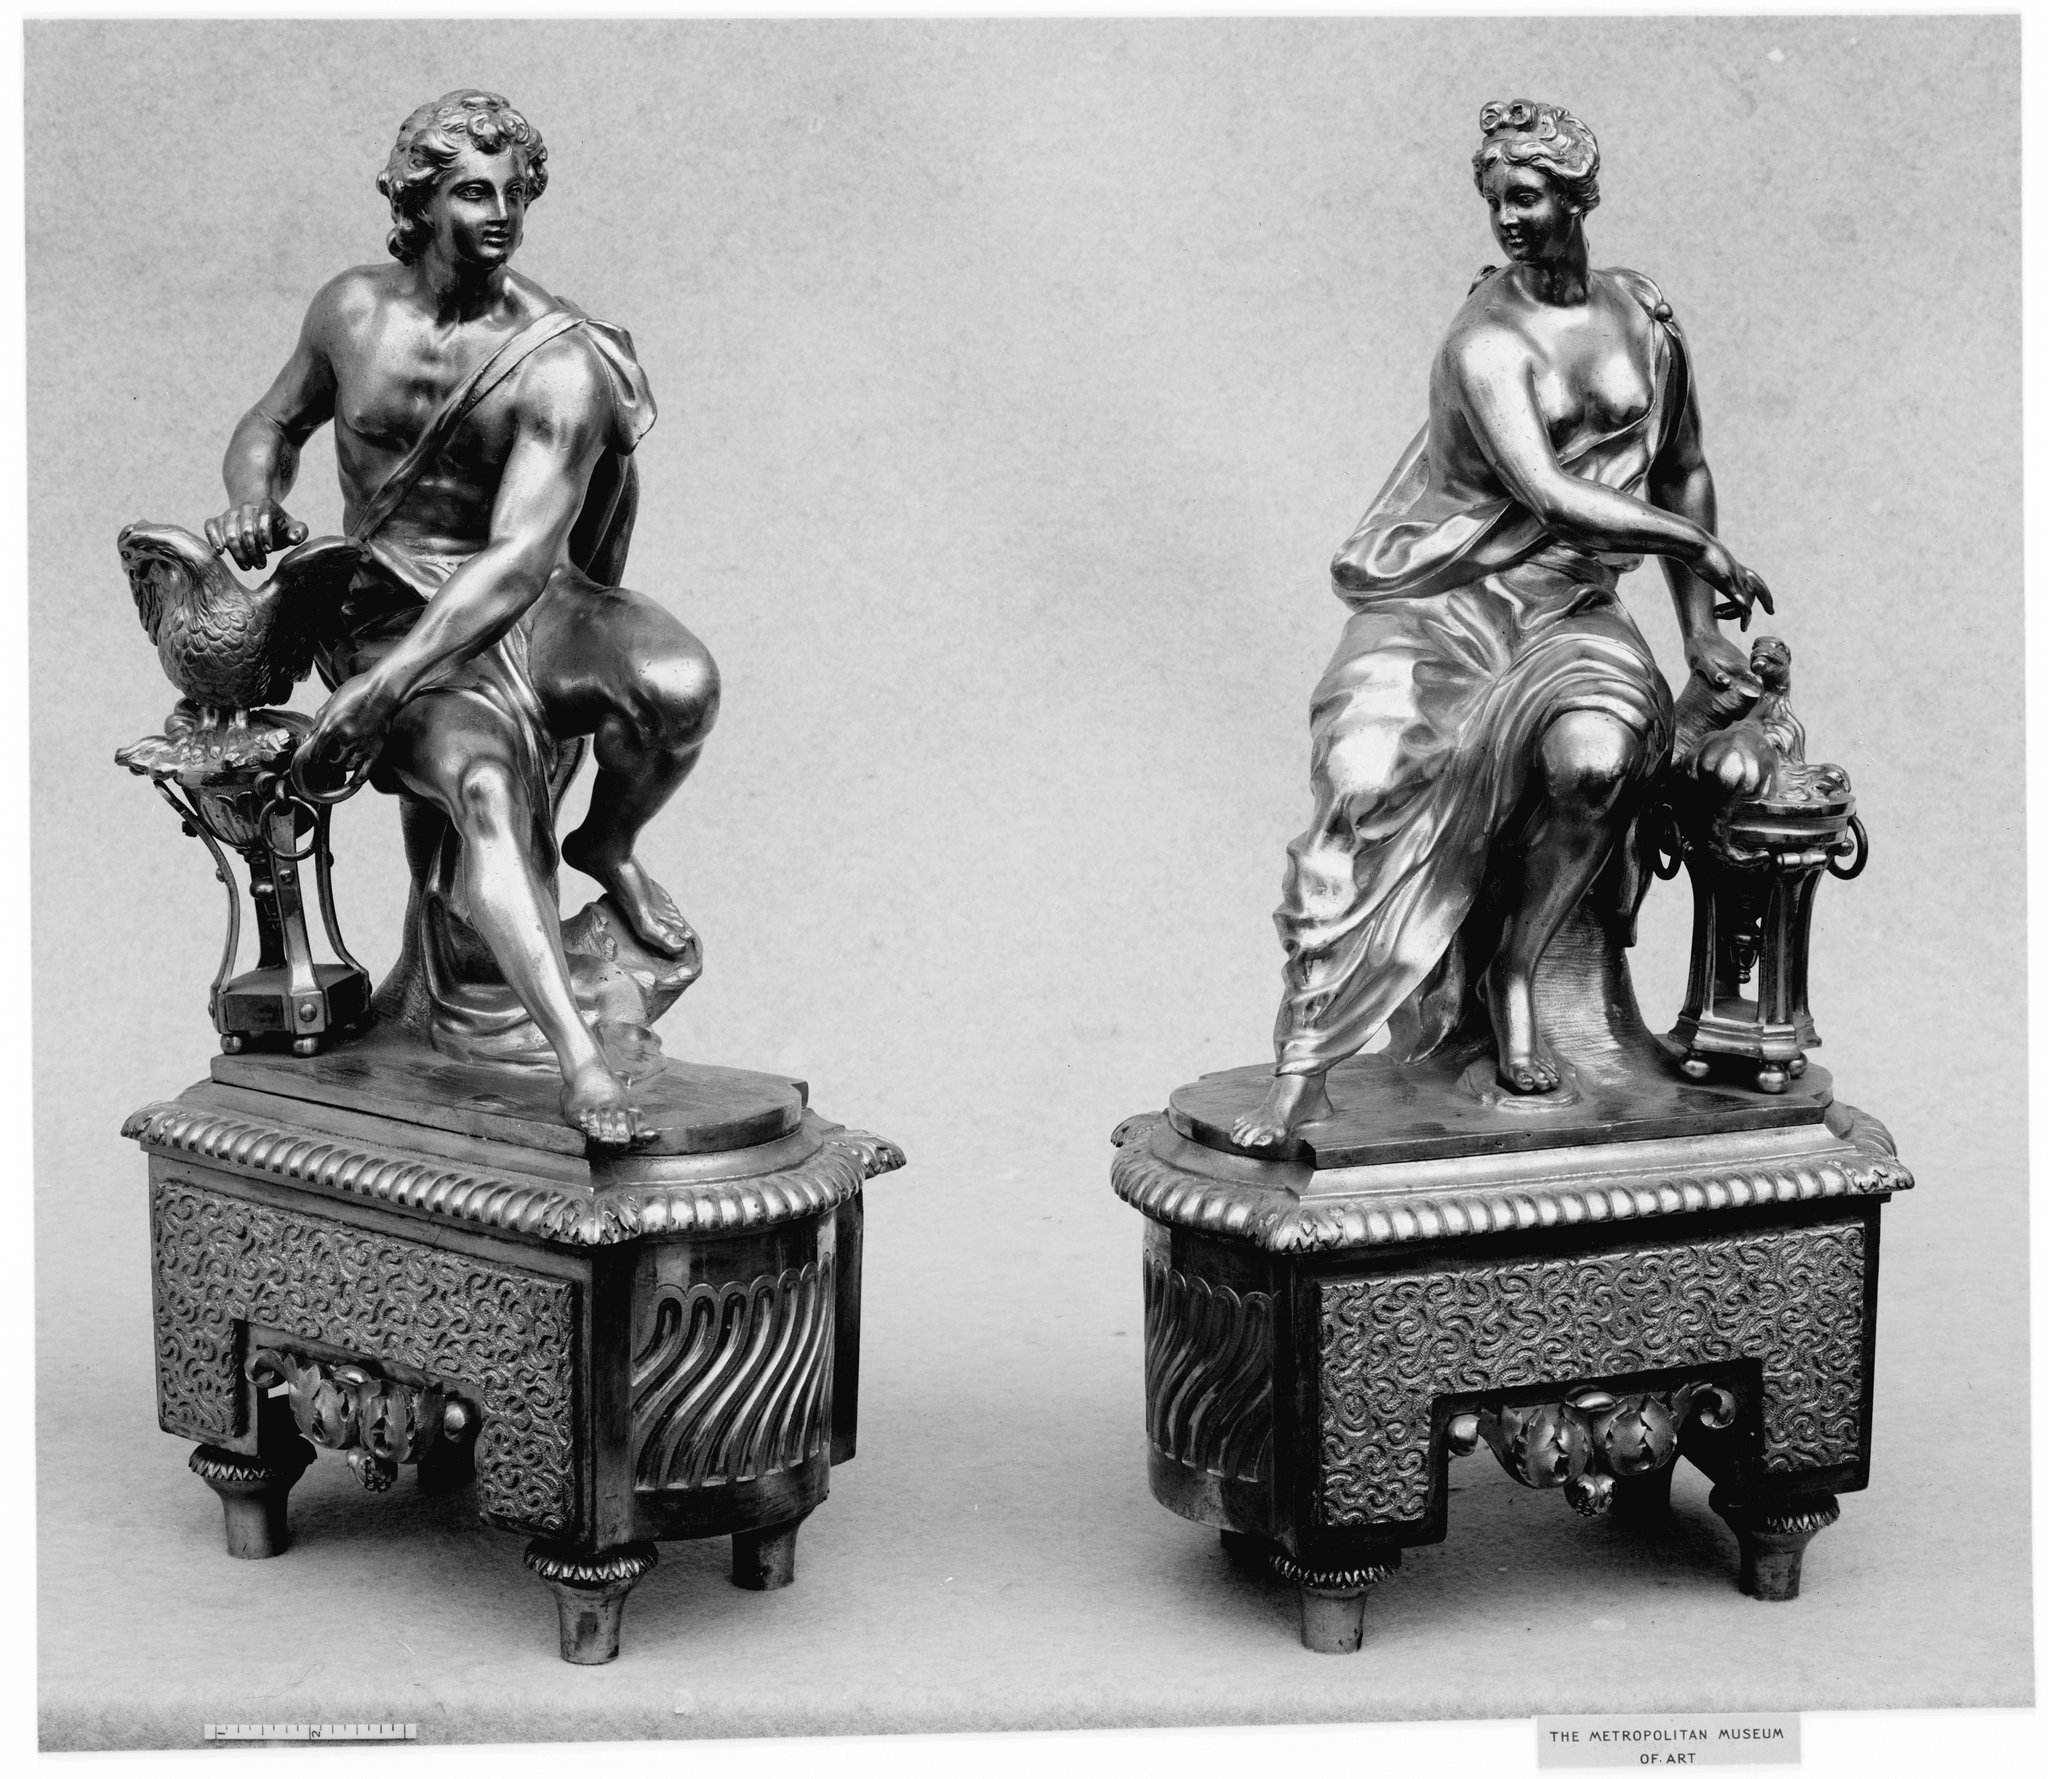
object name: andiron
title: Air and Fire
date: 1770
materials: gilt bronze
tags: birds,men,women